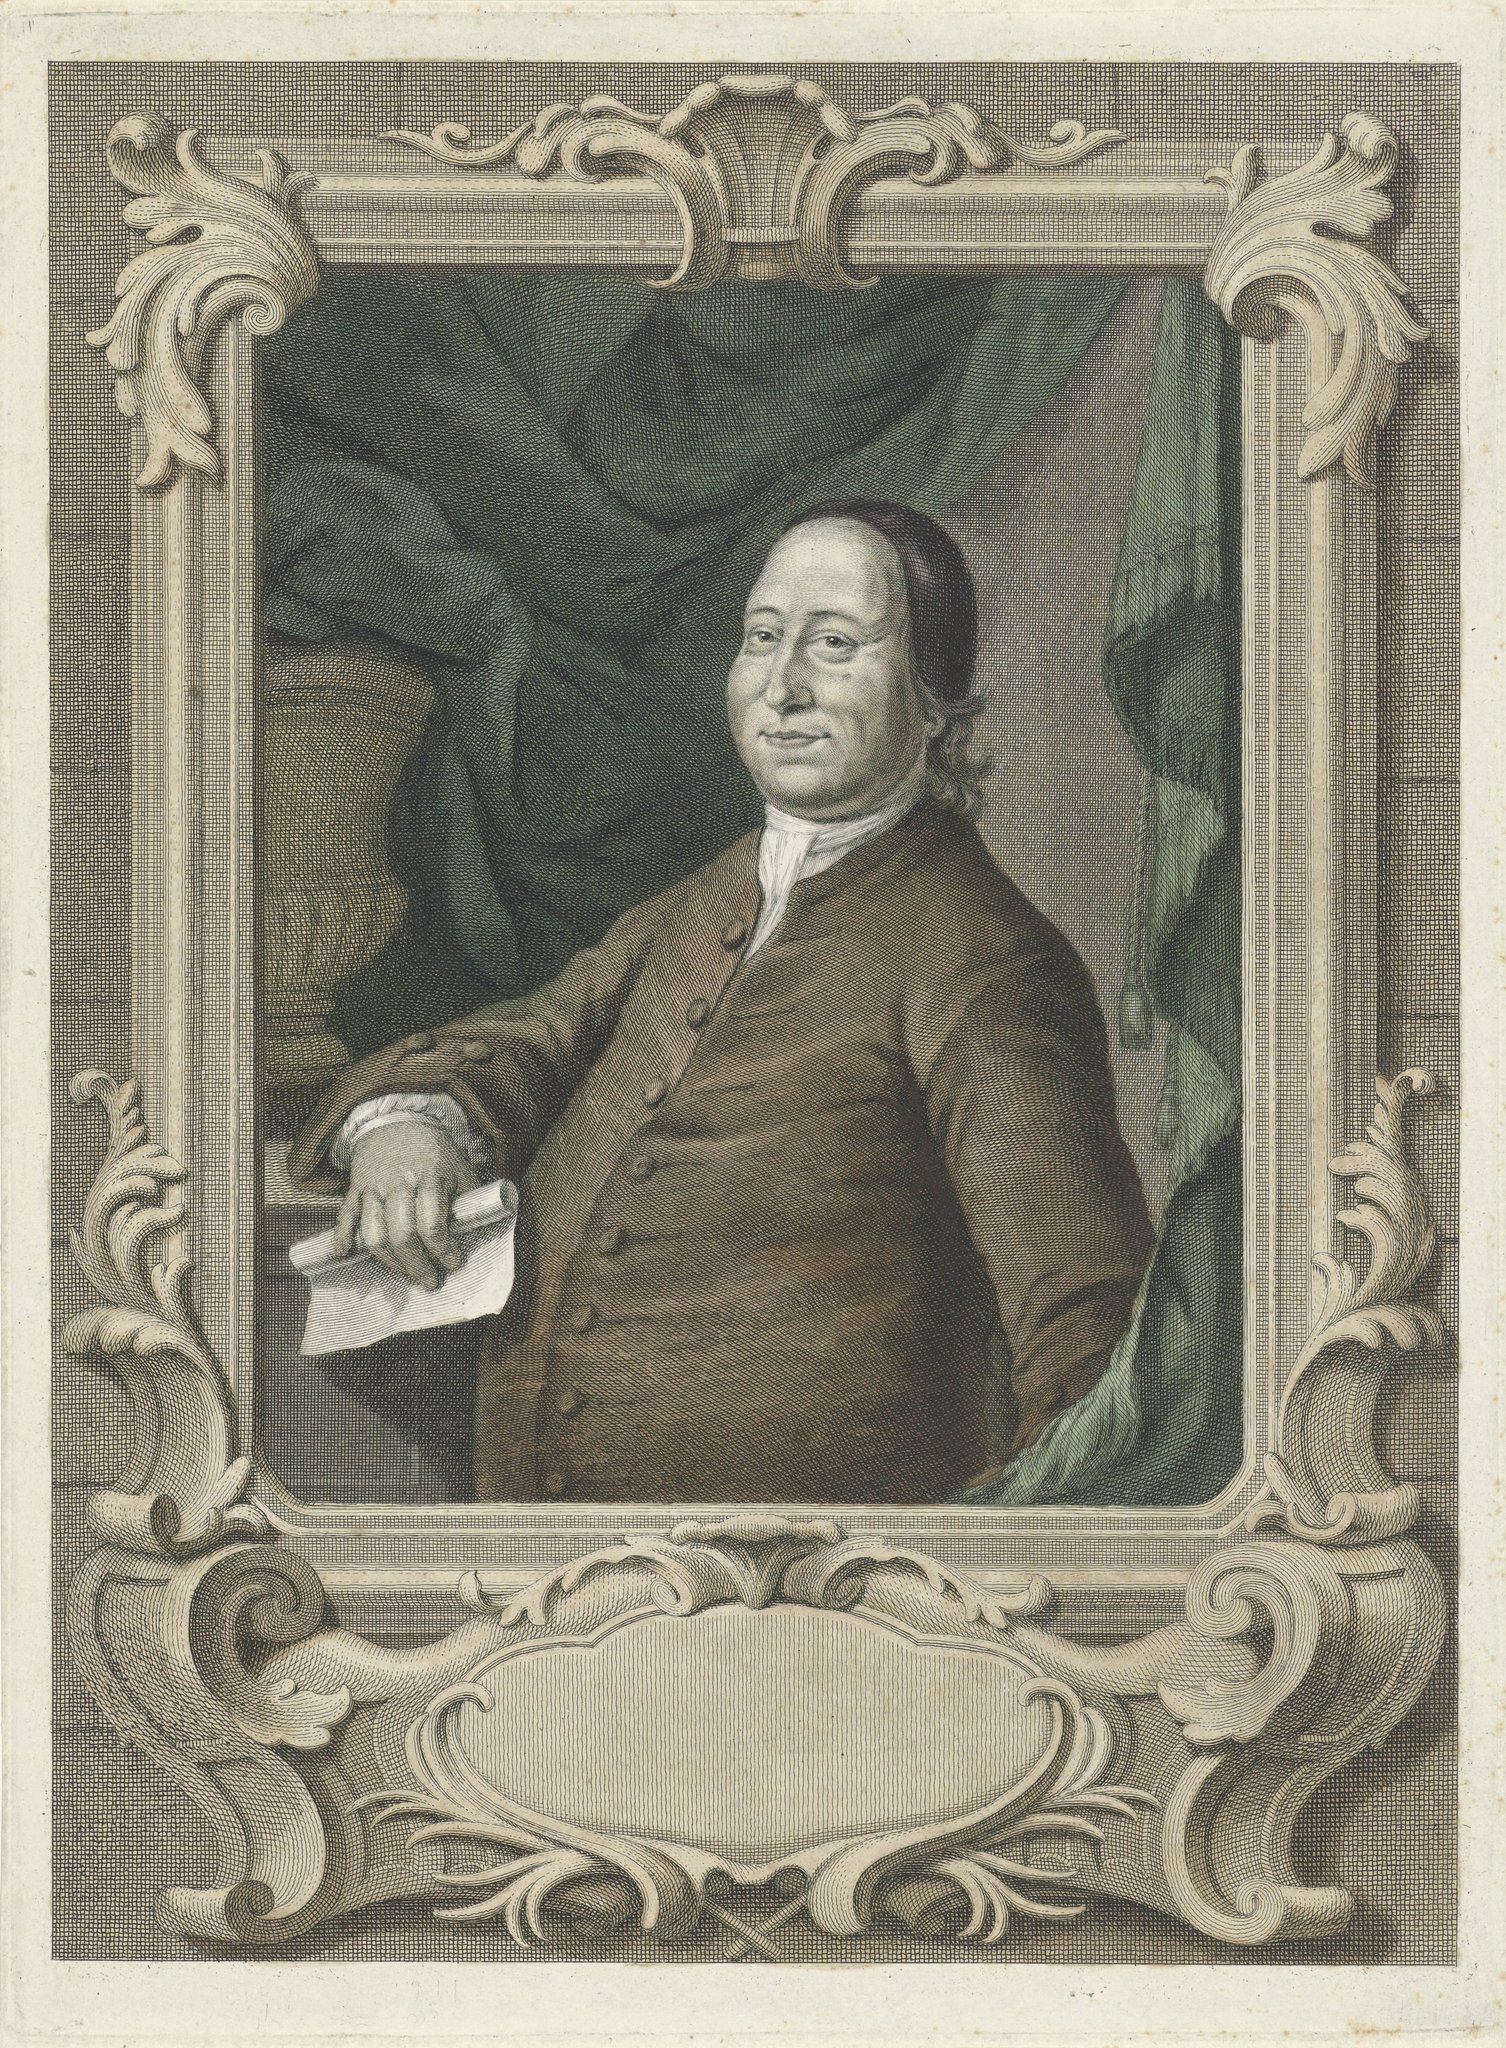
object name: print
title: Portret van Nikolaus Ludwig, graaf von Zinzendorff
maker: jacob houbraken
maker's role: draughtsman, print maker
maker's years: 1698-1780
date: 1762-1764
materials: paper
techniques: engraving, etching, hand coloring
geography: amsterdam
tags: nikolaus ludwig graf von zinzendorf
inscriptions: collector's mark: Lugt 2228